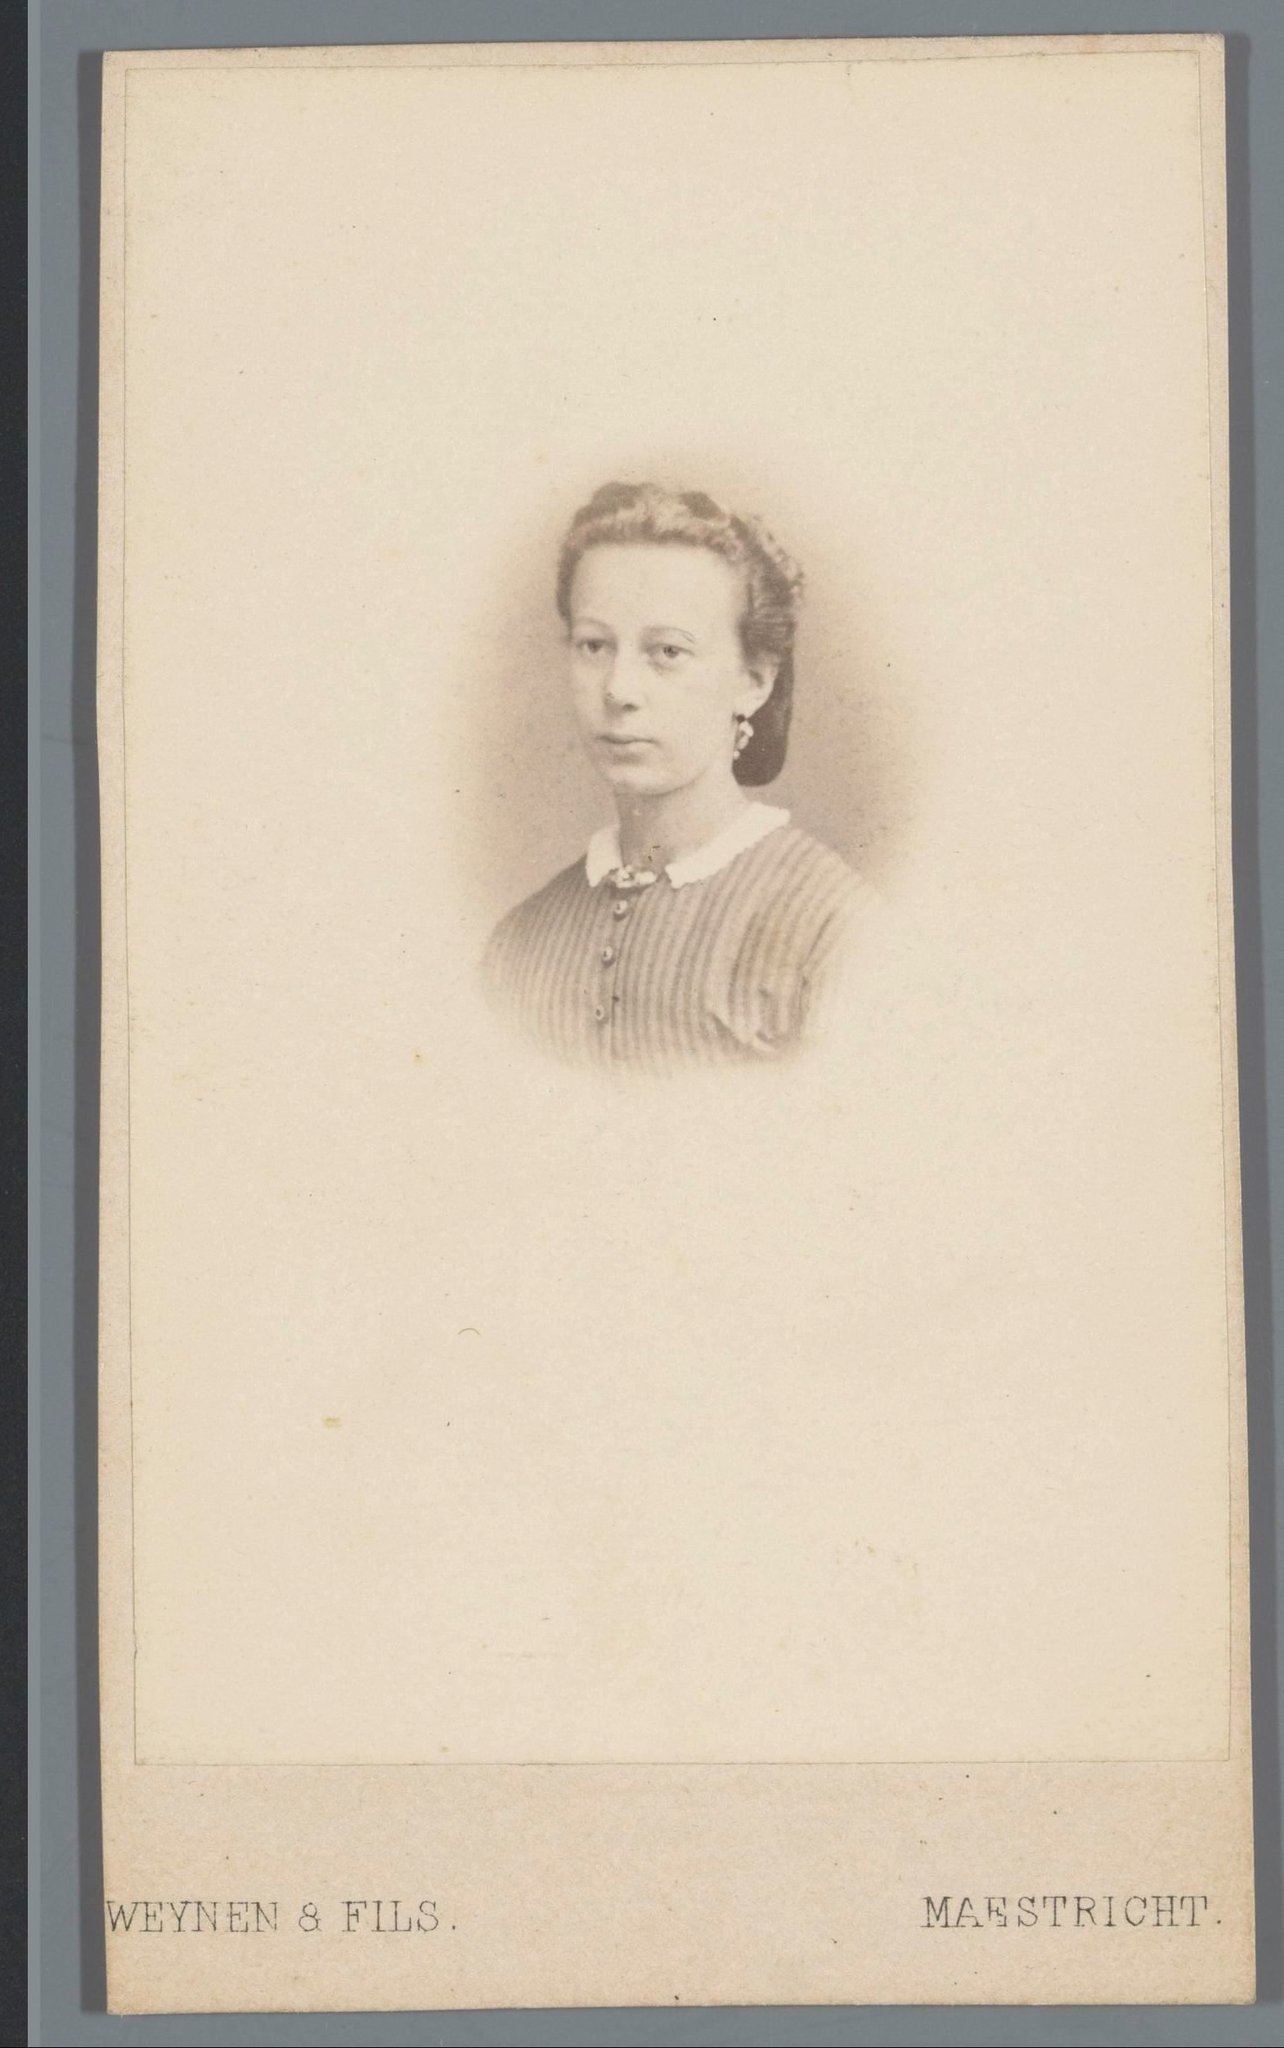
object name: photograph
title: Portret van een onbekende vrouw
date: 1854-1865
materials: cardboard, paper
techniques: albumen print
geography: maastricht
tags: adult woman, anonymous historical person portrayed, maastricht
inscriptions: inscription: ‘P. Weynen & Fils./ Photographie/ Rue du Casque, 1776./ Maestricht’, inscription: ‘Weynen & Fils. Maestricht.’